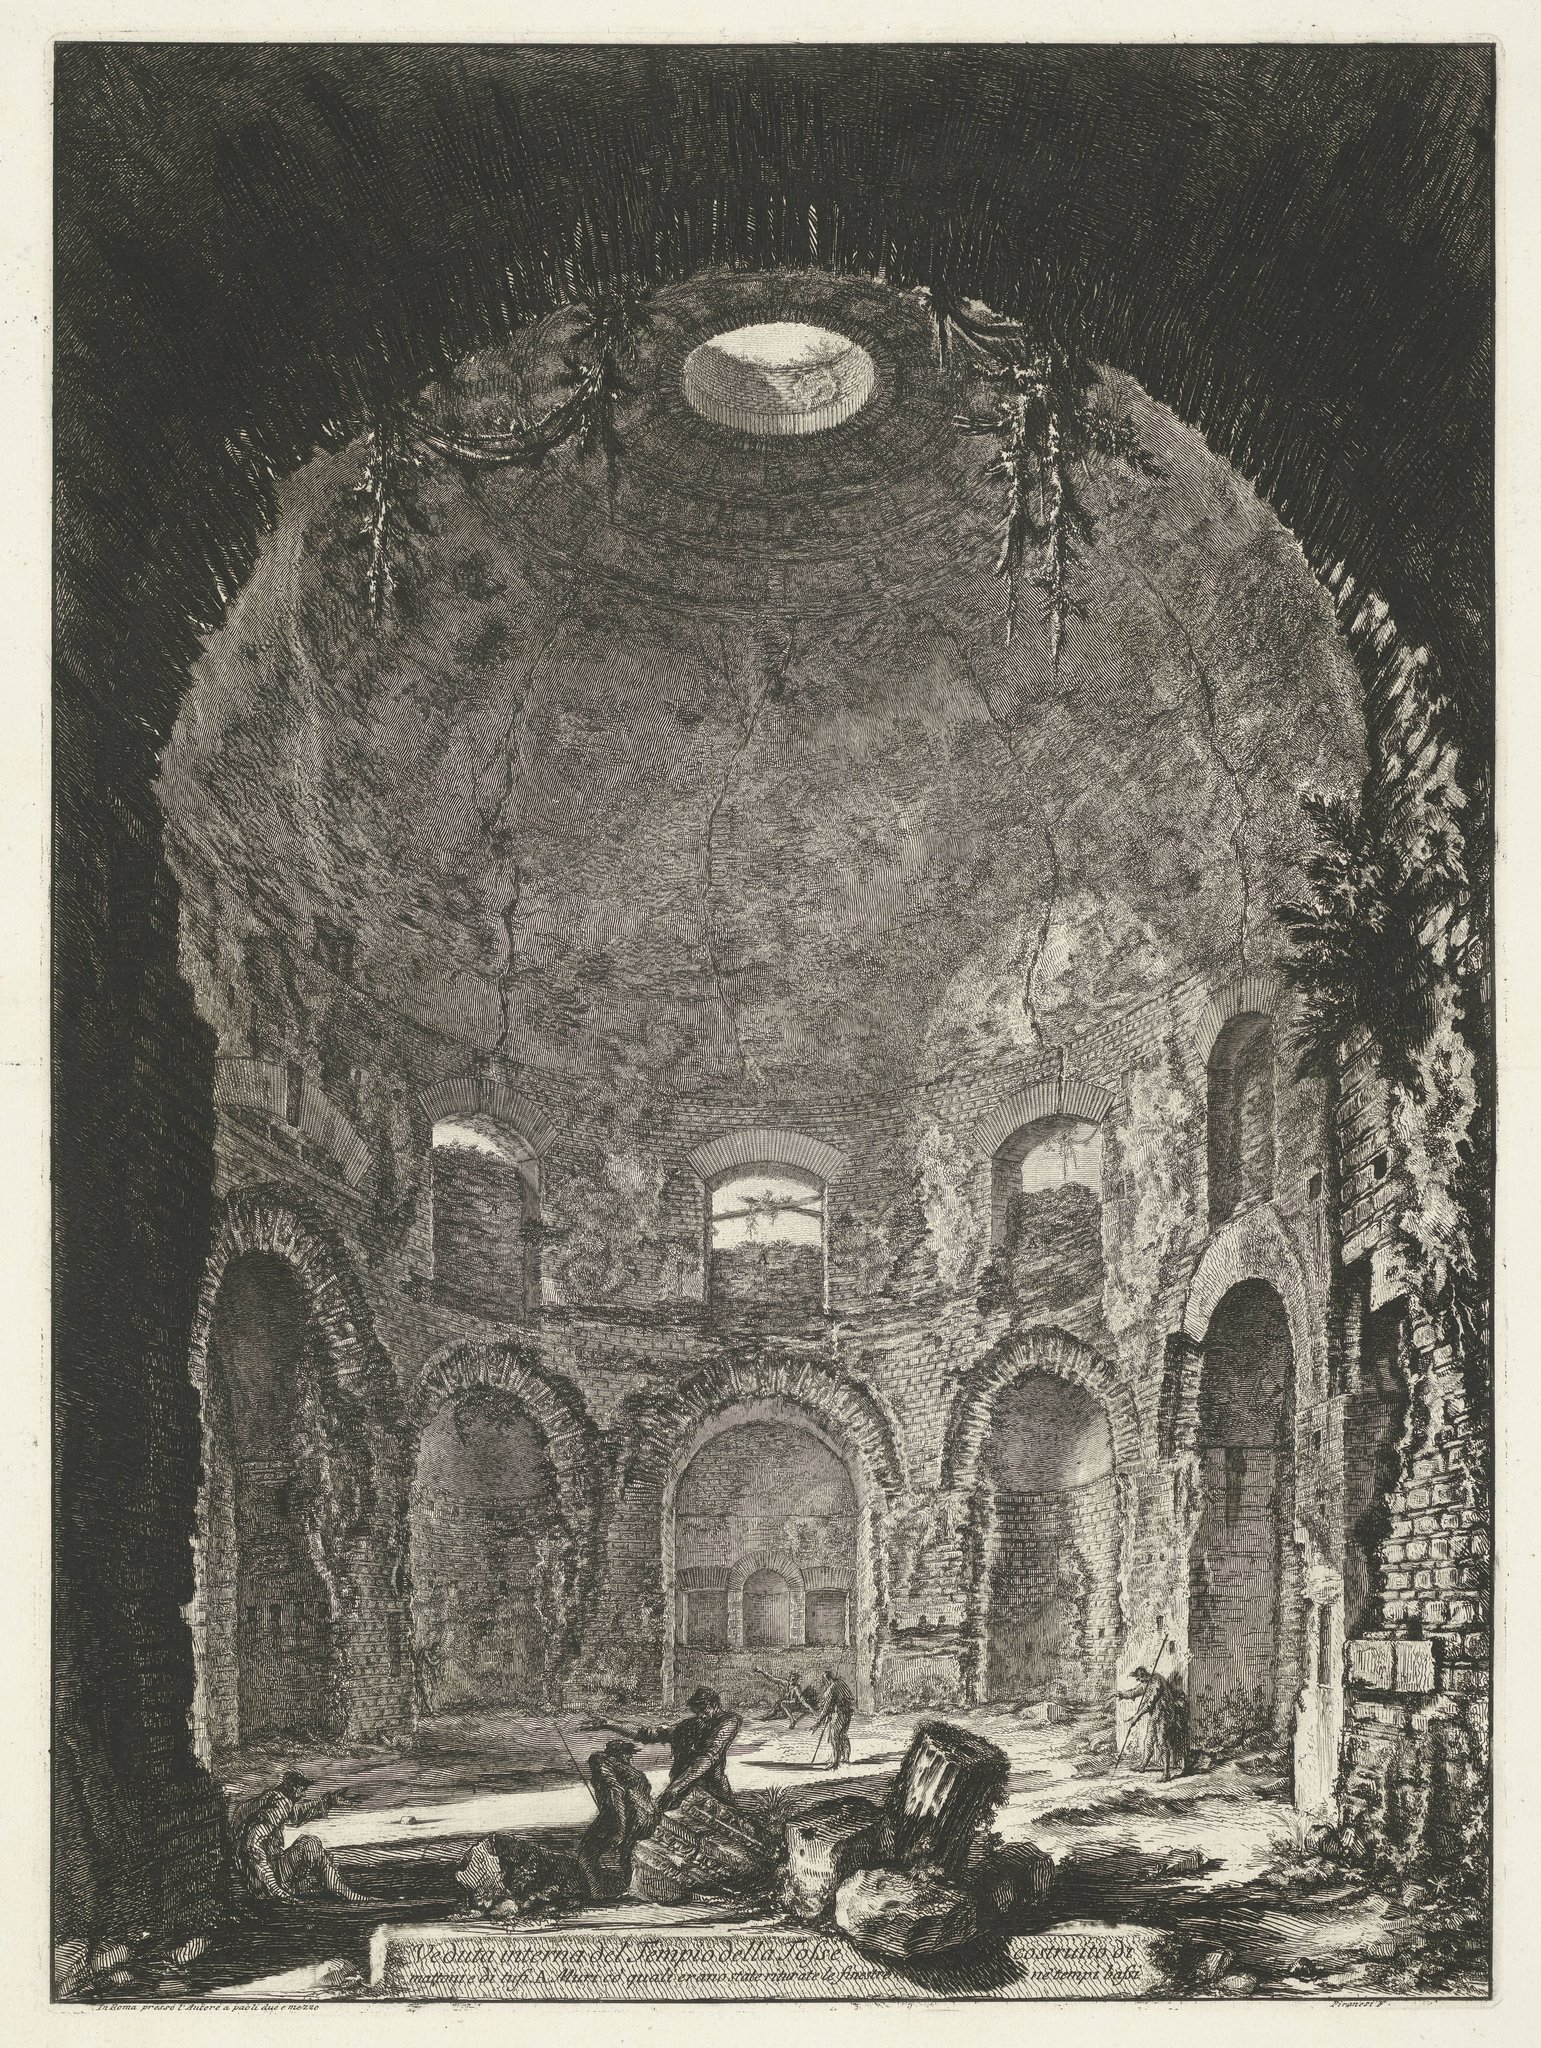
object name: print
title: Veduta interna del Tempio della Tosse (...)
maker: giovanni battista piranesi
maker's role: designer, draughtsman, print maker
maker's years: 1720-1778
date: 1748-1778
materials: paper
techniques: etching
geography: rome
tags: ruin of a building ~ architecture, landscape with ruins, temple, shrine ~ roman religion, tivoli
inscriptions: collector's mark: Lugt 2228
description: Deze prent maakt deel uit van de serie 'Vedute di Roma'. Piranesi werkte aan deze 135 platen tellende serie tussen 1748 en zijn dood in 1778. Francesco Piranesi voegde later nog twee prenten toe aan de reeks van zijn vader.